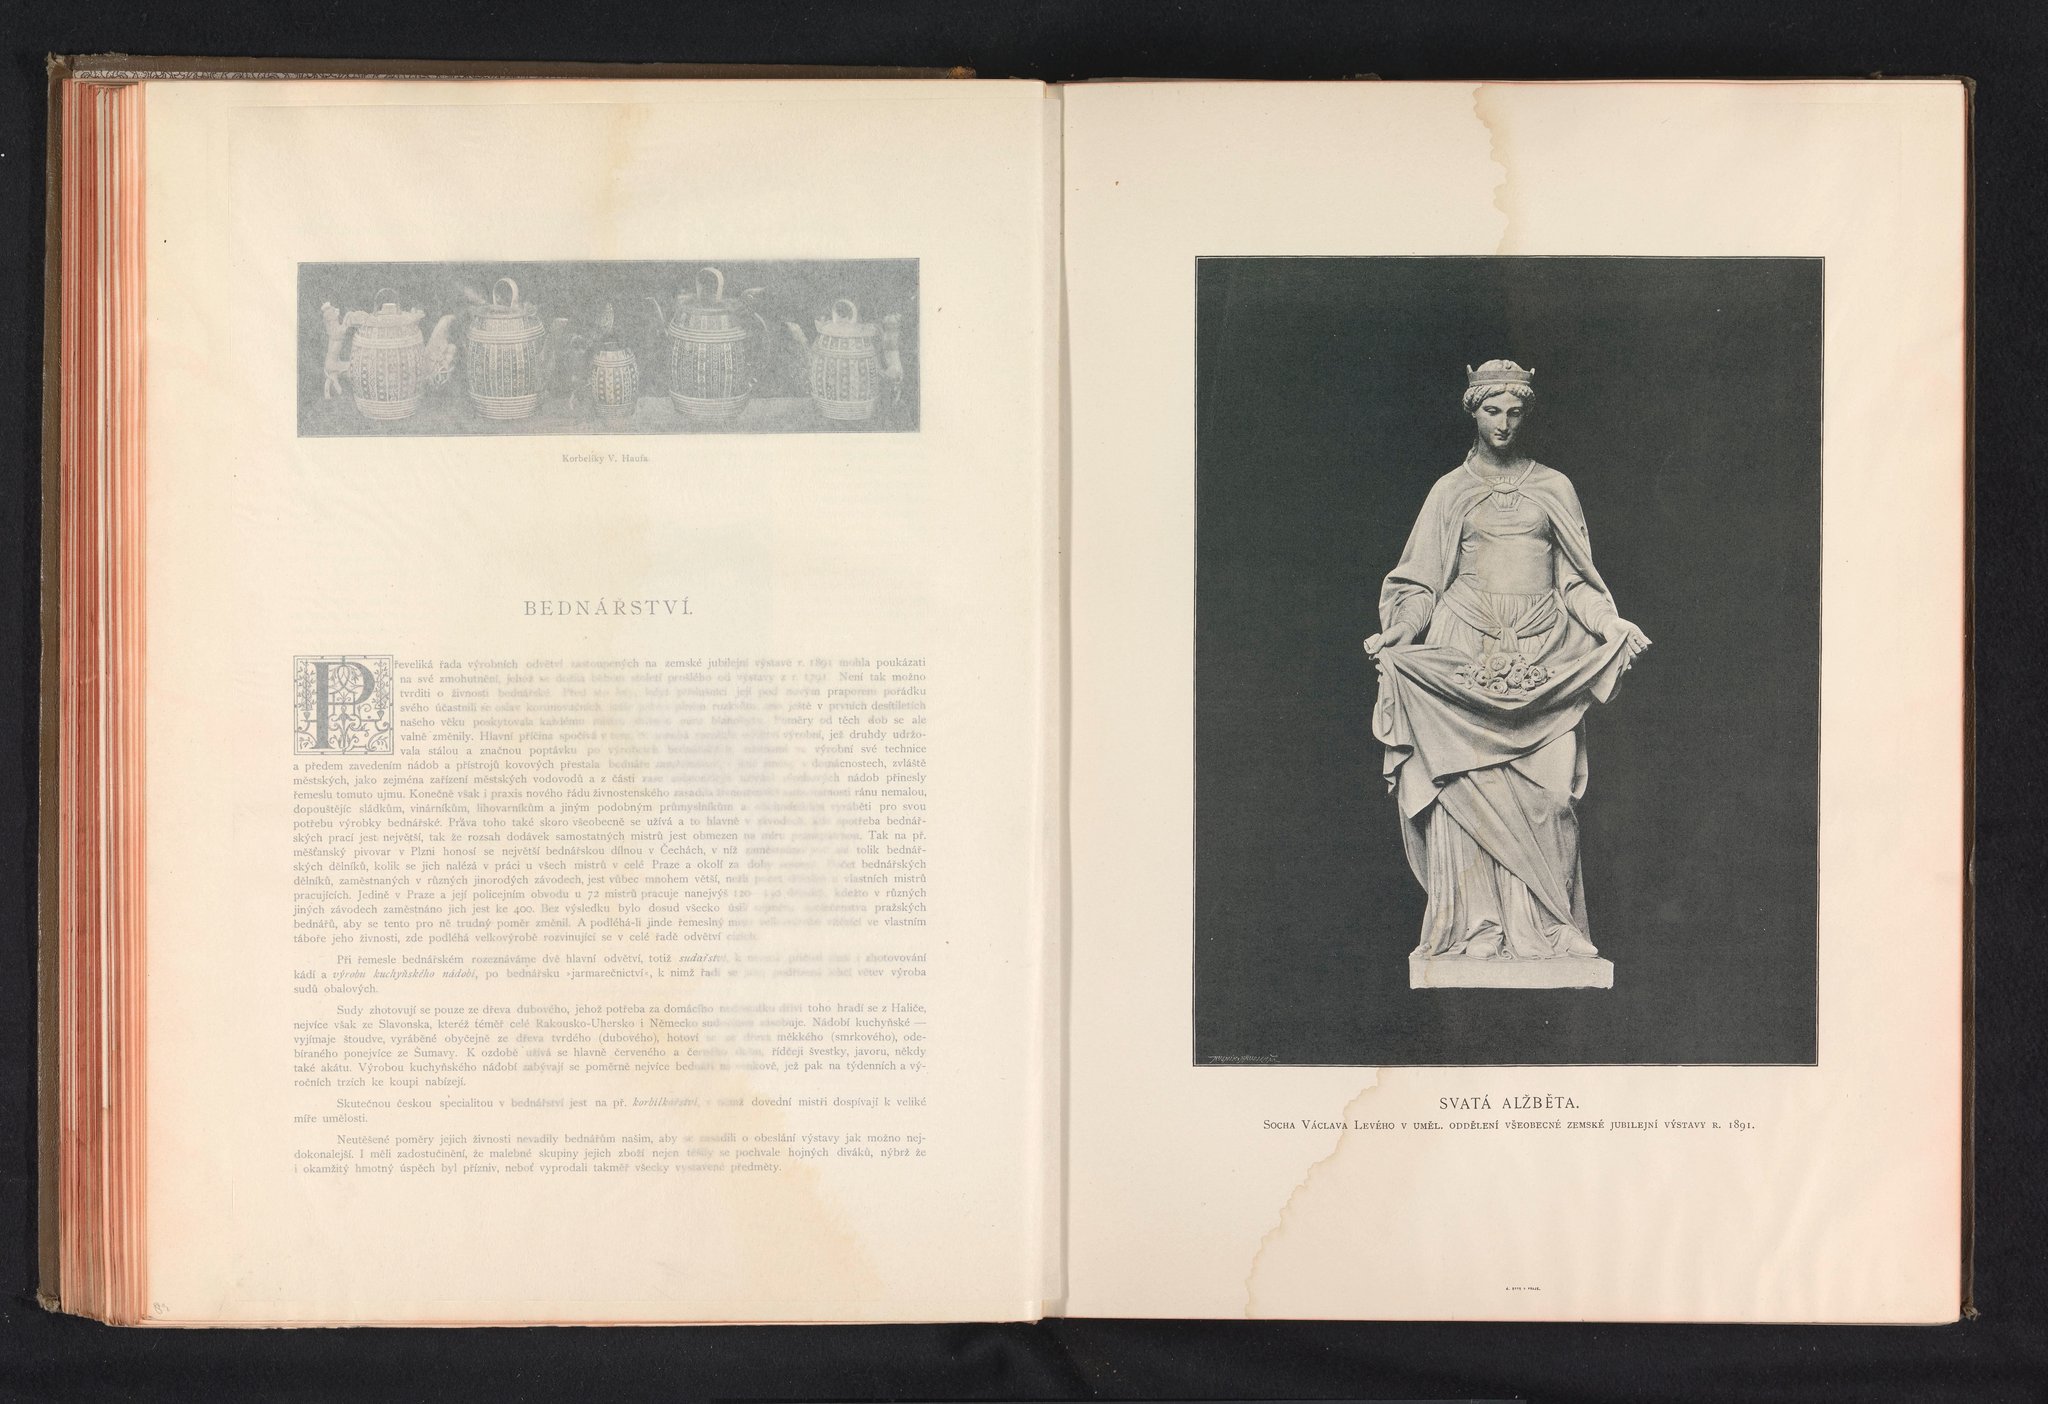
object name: page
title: Sculptuur van de heilige Elisabeth van Thüringen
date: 1890-1895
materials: paper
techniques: autotype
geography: prague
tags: the wife and widow of the landgrave of thuringia, and franciscan tertiary, elisabeth of hungary; possible attributes: beggar, cripple, fish, loaves, leper, model of church, pitcher, roses in lap, scald-head, three crowns, sculpture